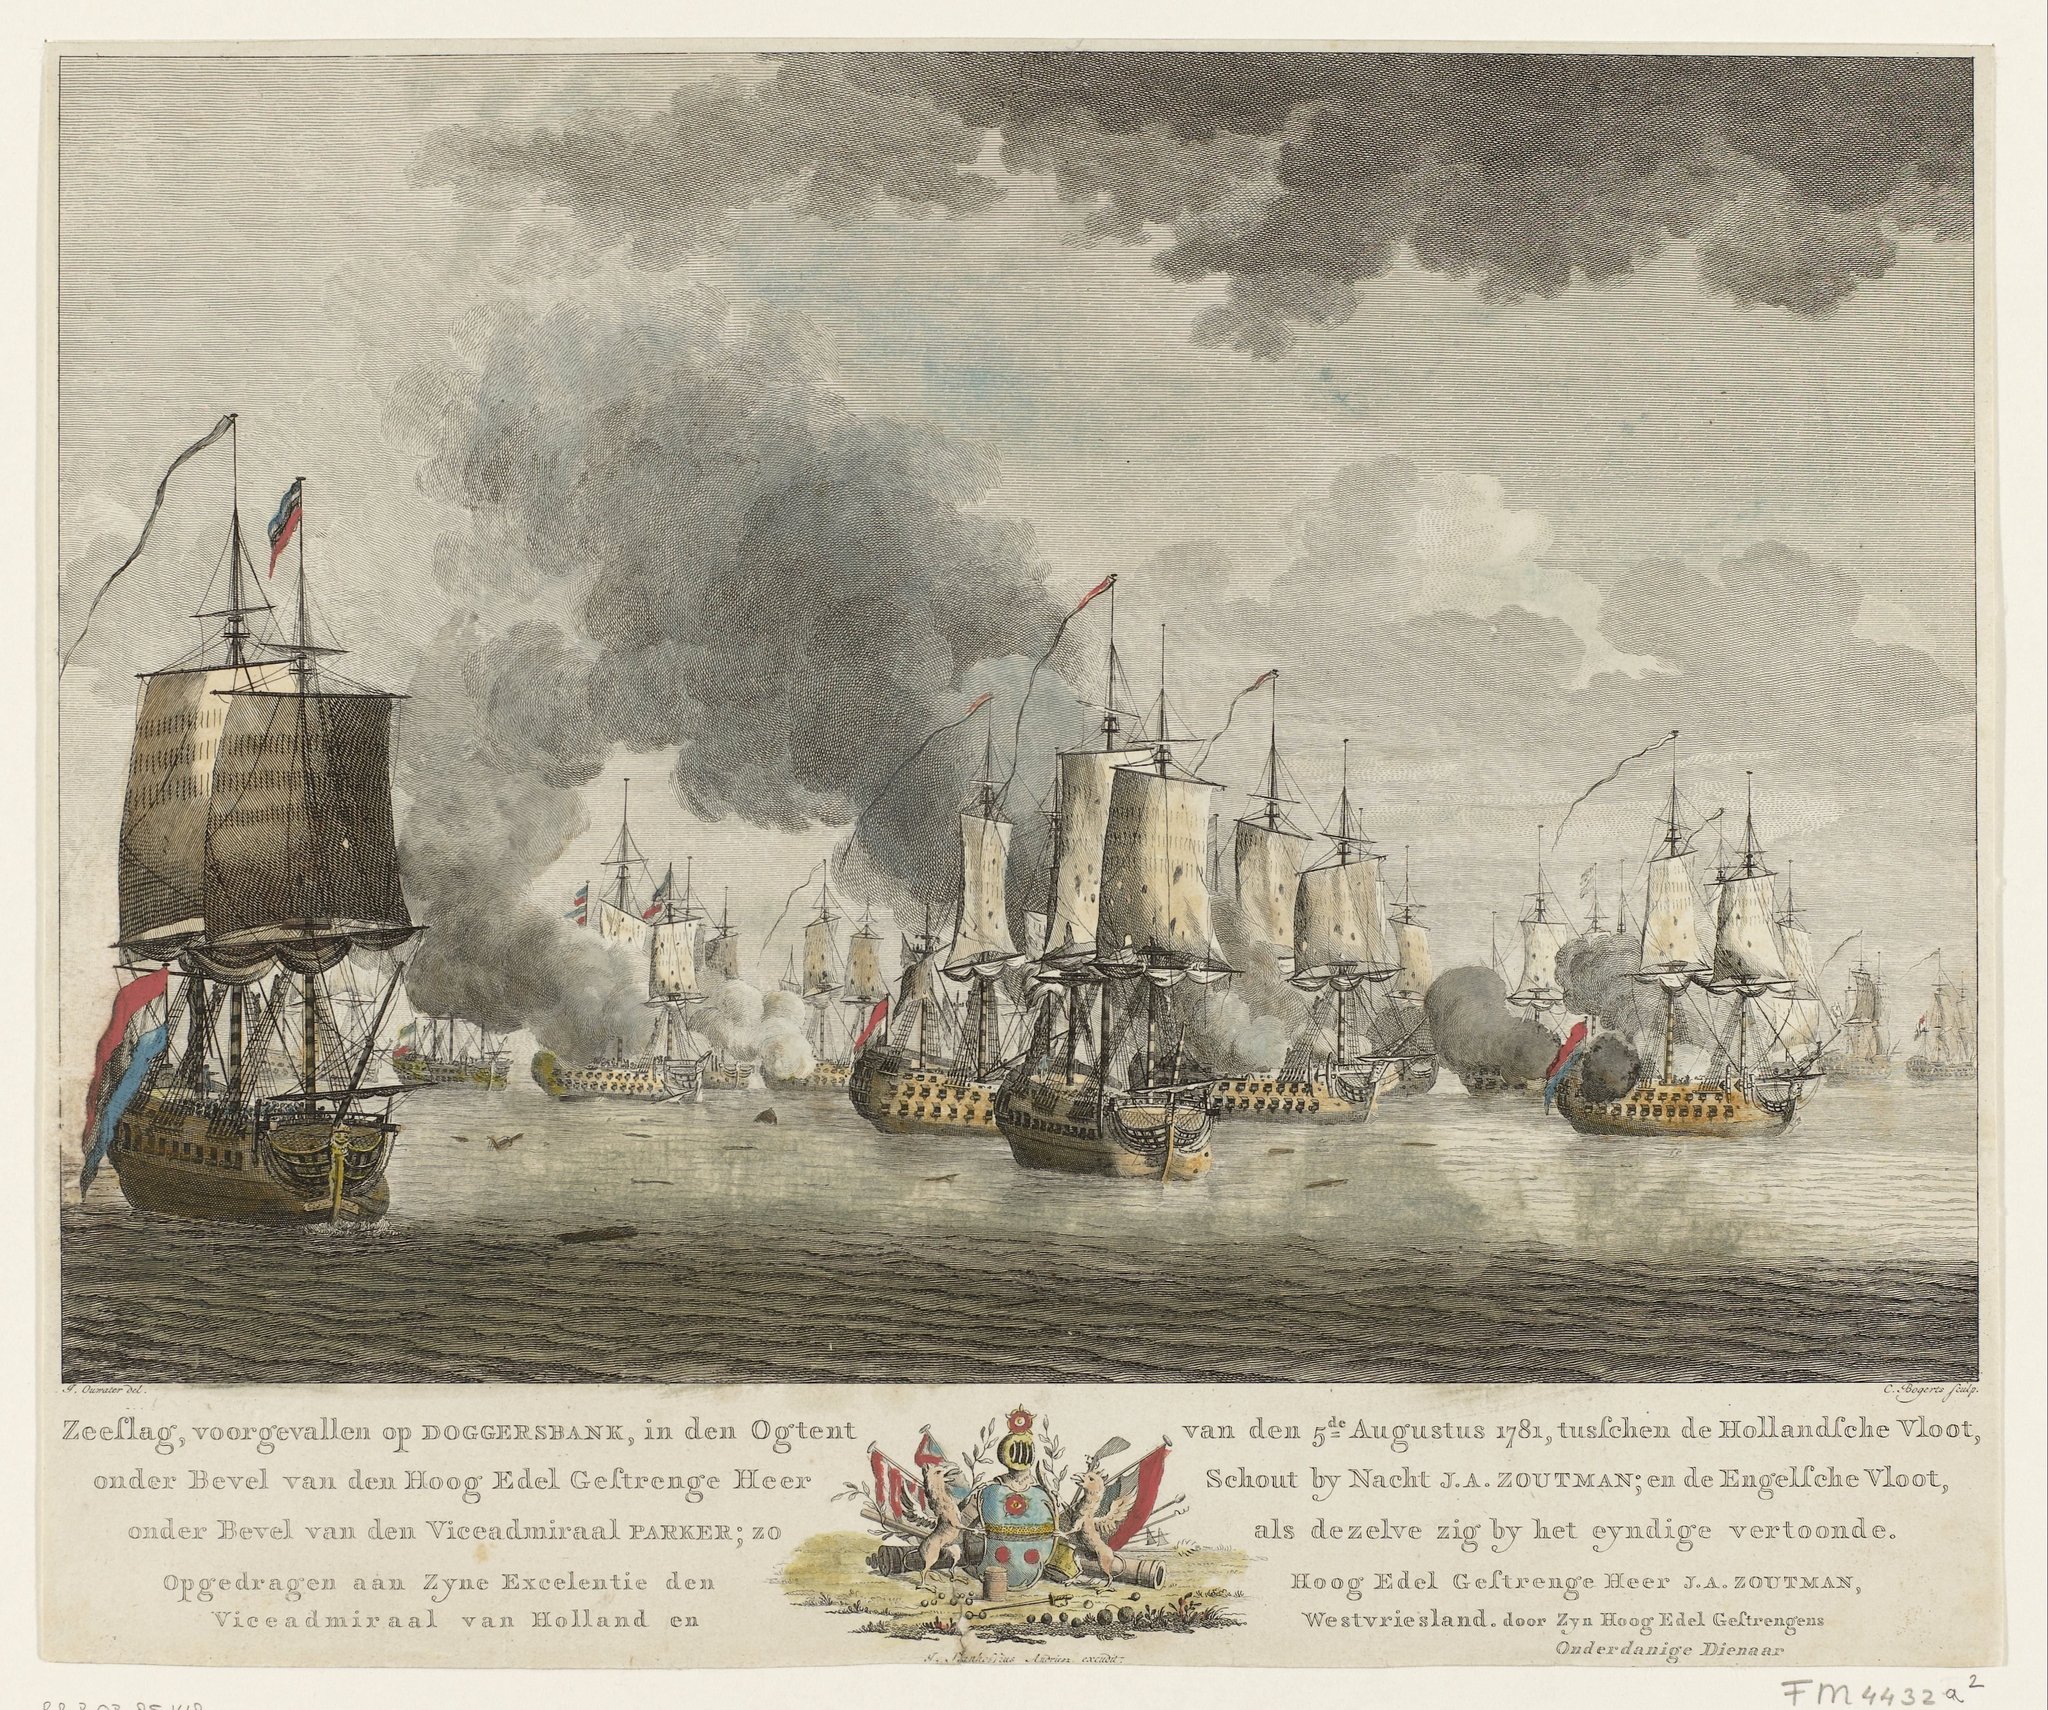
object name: print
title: Zeeslag bij Doggersbank, 1781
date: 1781-1784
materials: paper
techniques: engraving, etching, hand coloring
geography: northern netherlands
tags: the hague, johan arnold zoutman, hyde parker, battle (+ naval force)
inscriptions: collector's mark: Lugt 2228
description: De Nederlandse en Engelse schepen tijdens de zeeslag bij Doggersbank op 5 augustus 1781 tussen de Nederlandse vloot onder schout-bij-nacht Johan Zoutman en de Engelse vloot onder vice-admiraal Hyde Parker. In de marge de titel en opdracht in het Nederlands en in het midden het wapen van Zoutman. Onderdeel van een paar.